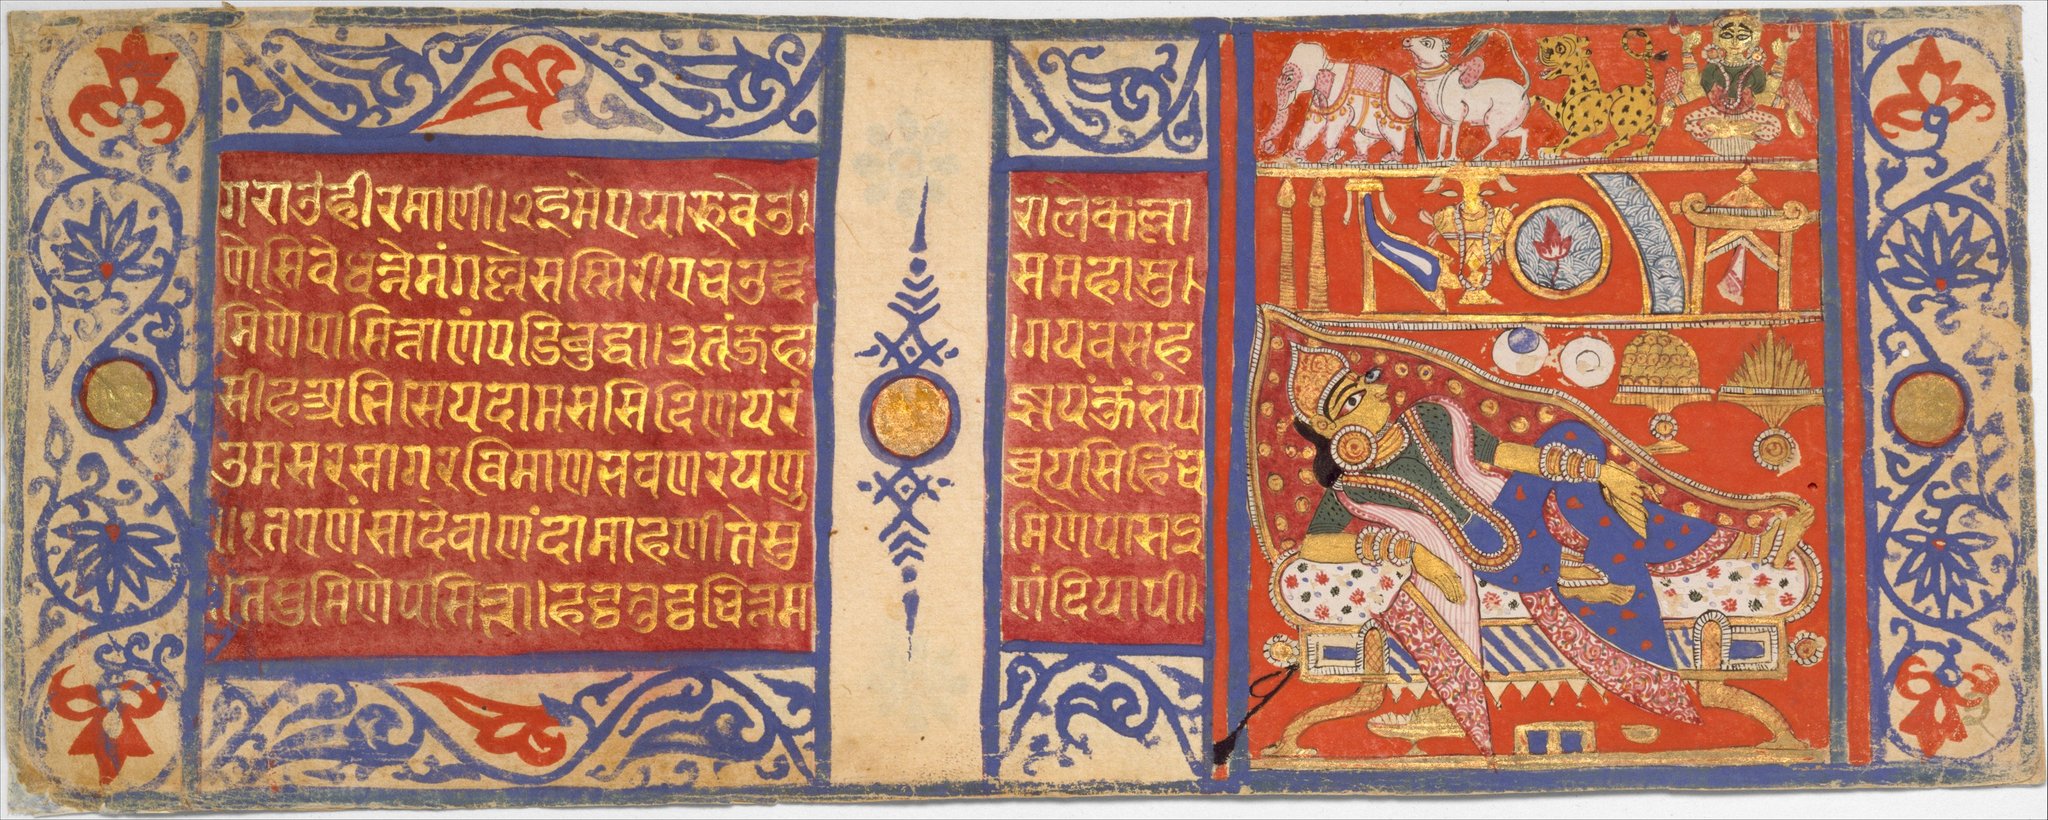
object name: folio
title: Devananda's Fourteen Auspicious Dreams Foretelling the Birth of Mahavira: Folio from a Kalpasutra Manuscript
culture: indian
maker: master of the jaunpur kalpasutra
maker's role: artist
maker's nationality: indian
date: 1465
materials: paper, watercolor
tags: women,elephants